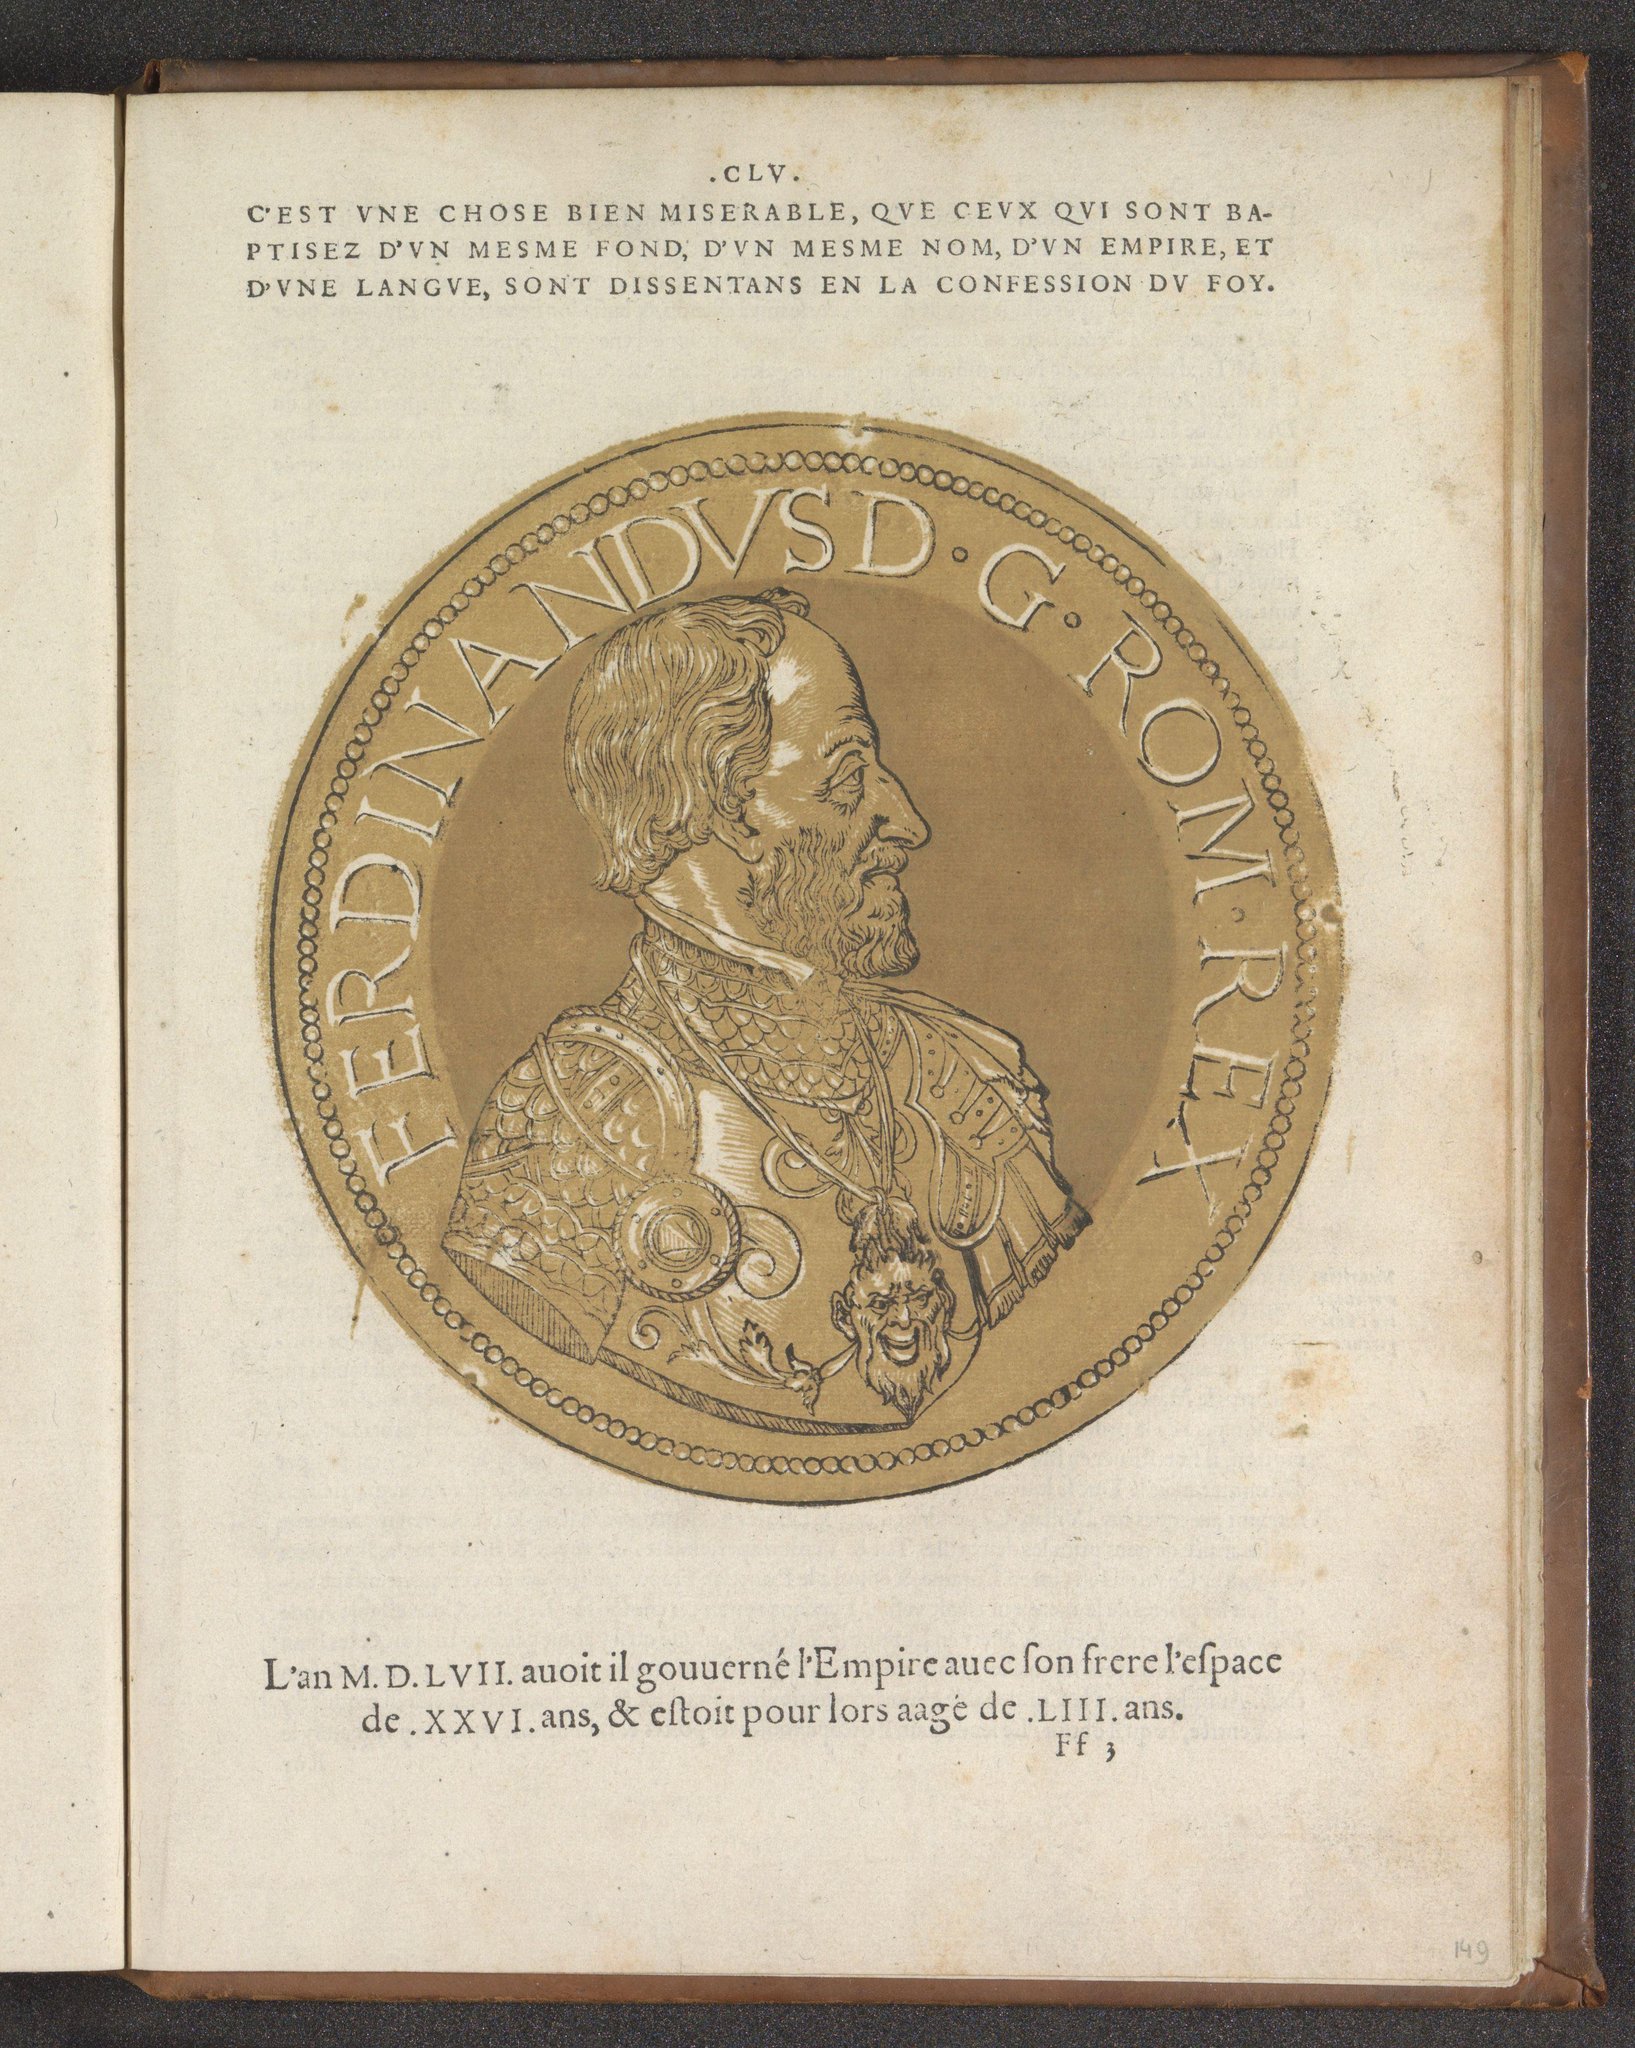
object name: print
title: Portret van keizer Ferdinand I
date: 1557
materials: paper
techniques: woodcut, letterpress printing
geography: antwerp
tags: ferdinand i van habsburg (duits keizer), emperor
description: Portret van keizer Ferdinand I, op een munt met randschrift. De prent maakt deel uit van een boek over de keizers vanaf Julius Caesar tot en met Karel V en zijn broer Ferdinand.